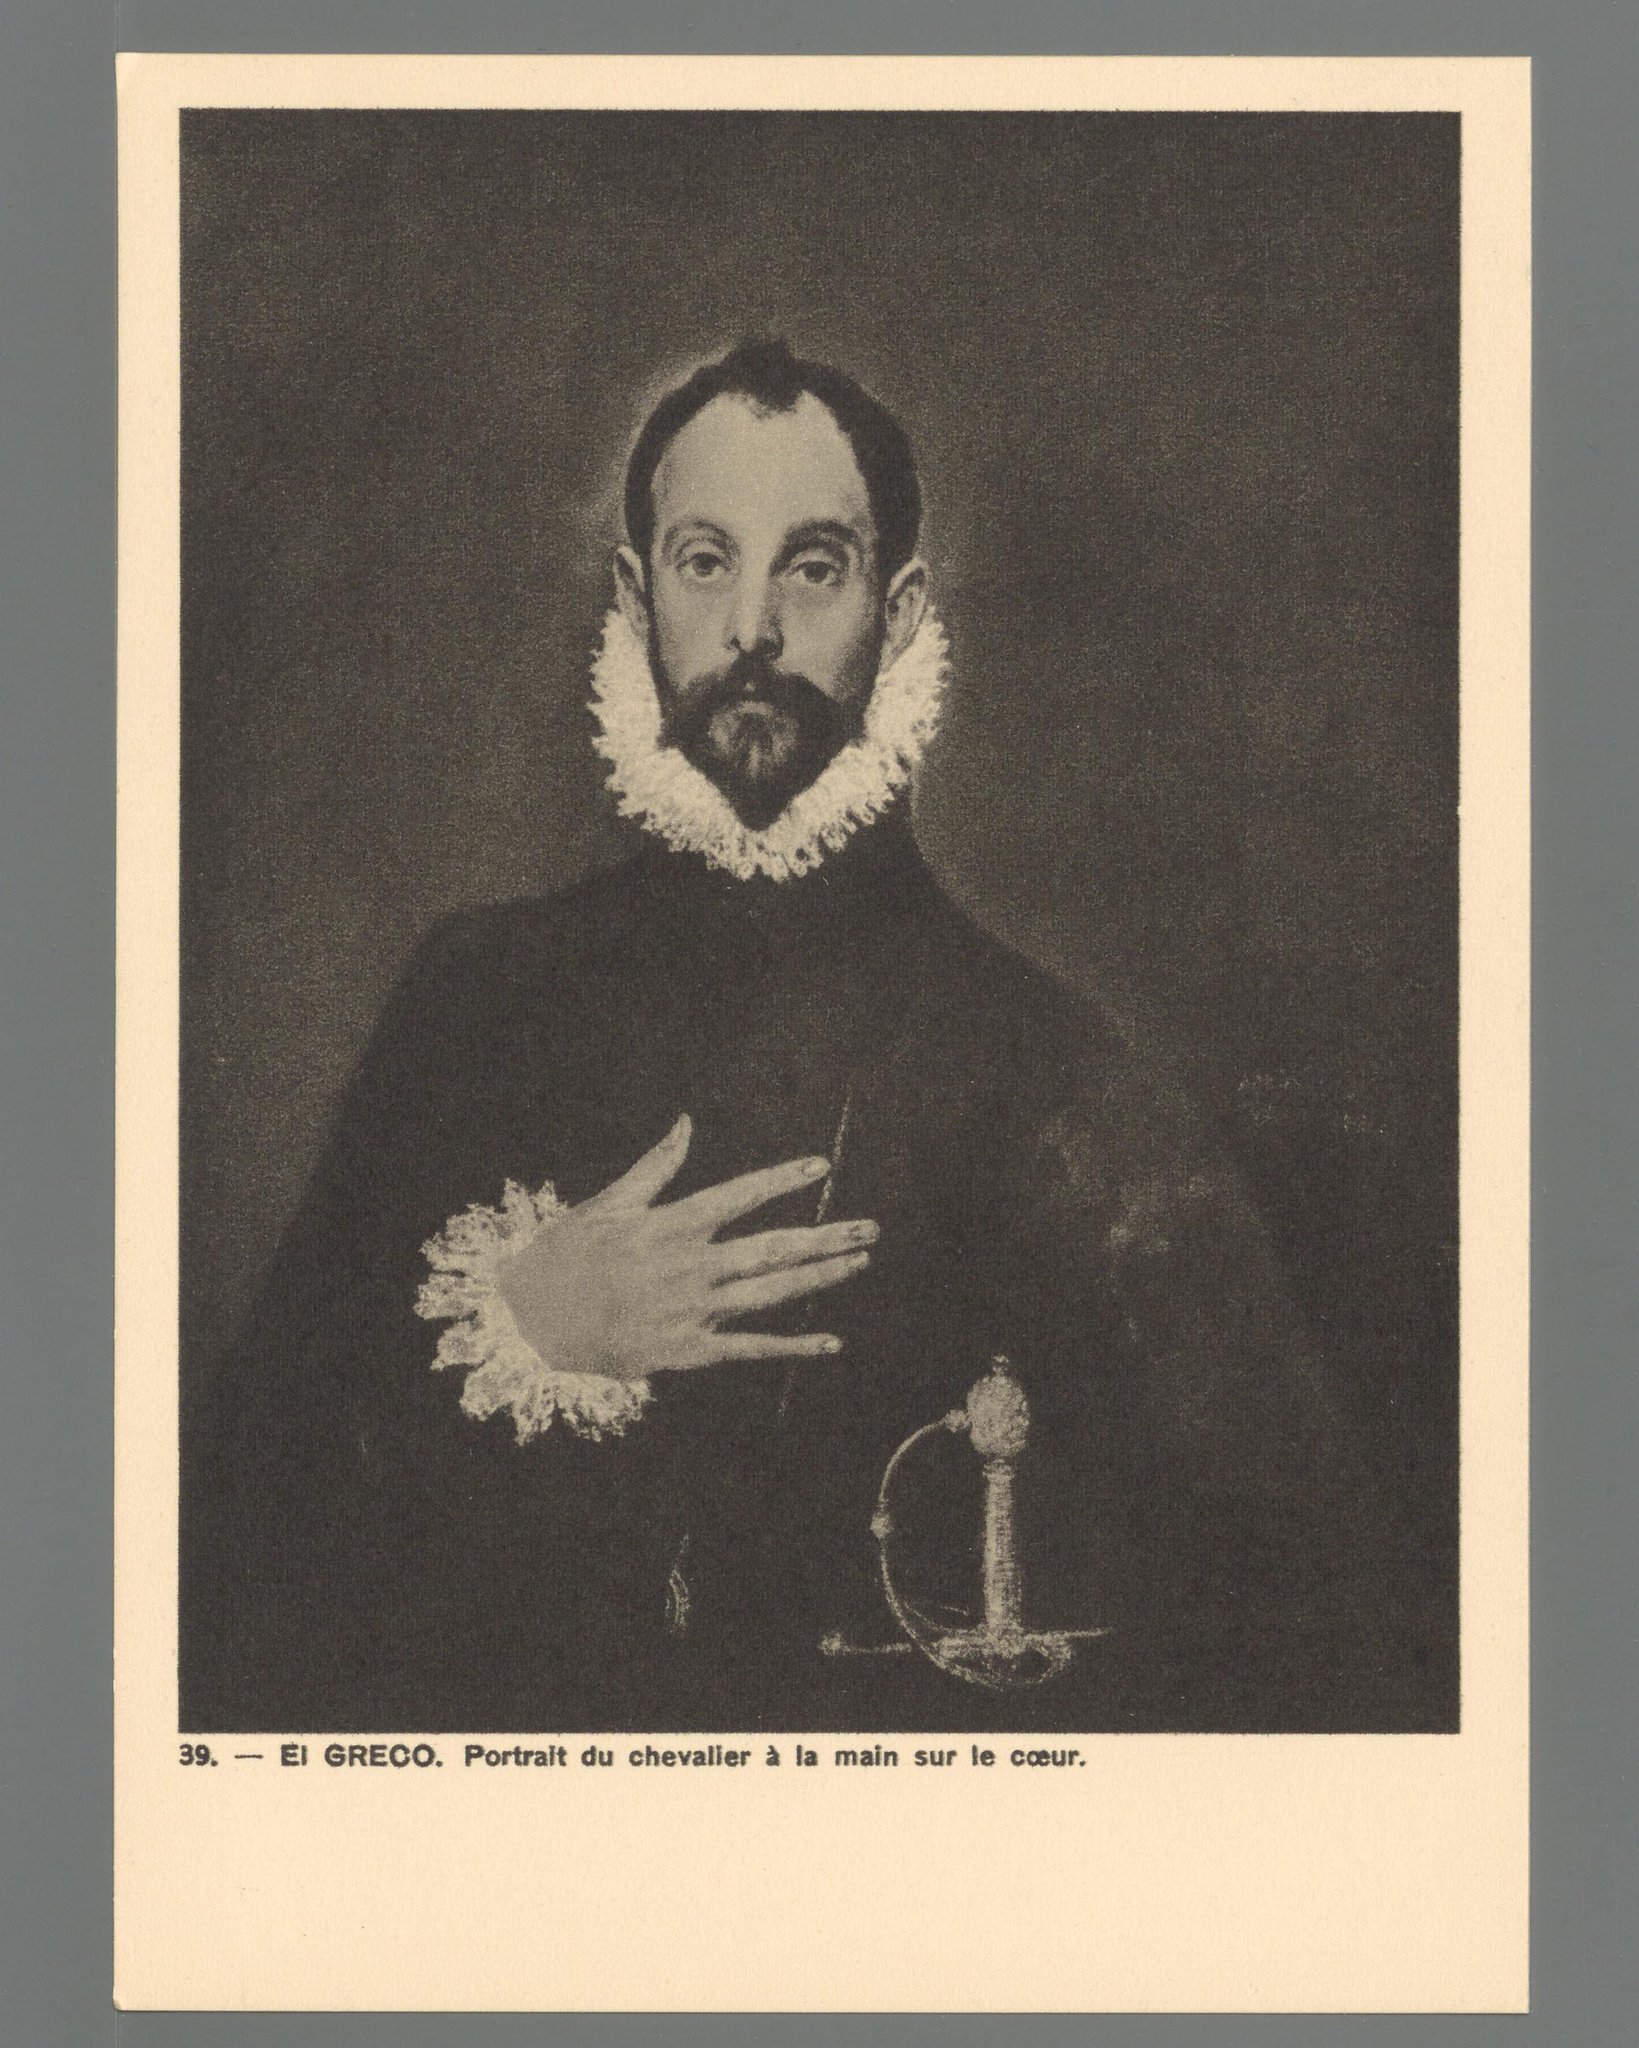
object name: photomechanical print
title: Portrait du chevalier à la main sur le coeur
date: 1932-1940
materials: cardboard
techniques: rotogravure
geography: geneva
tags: hacking and thrusting weapons: sword, historical persons not known by name